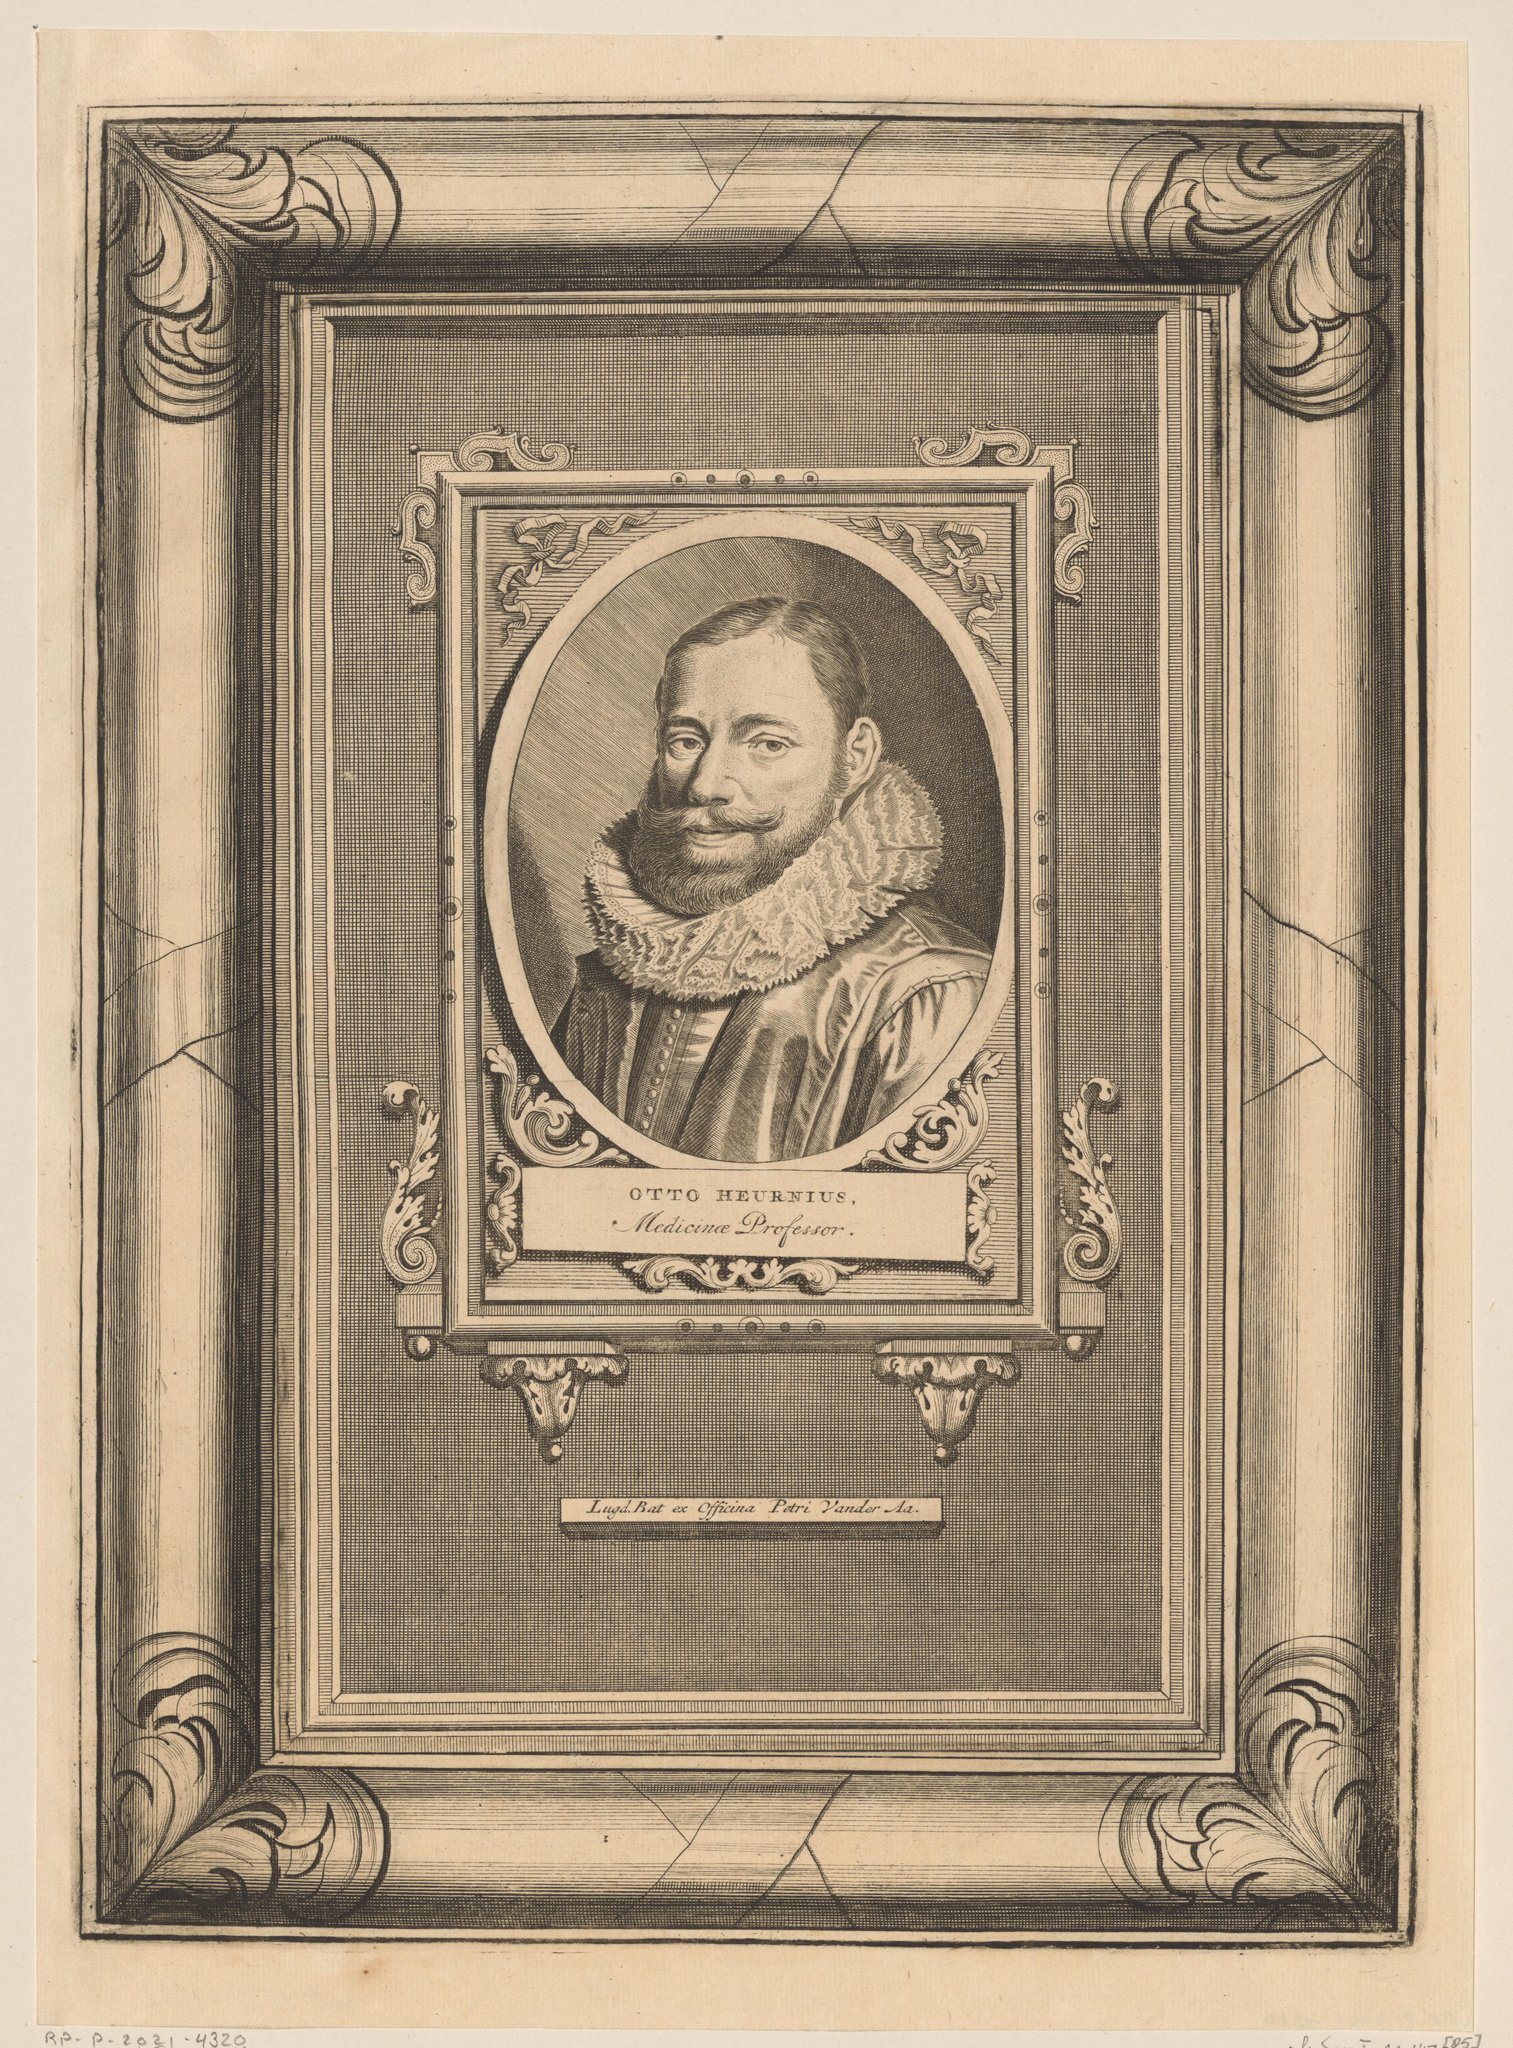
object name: print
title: Portret van Otto Heurnius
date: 1675-1733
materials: paper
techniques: engraving, etching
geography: leiden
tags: otto heurnius, historical persons, physician, doctor, professor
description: Prent met enkele omlijsting gebruikt in: Fundatoris, curatorum et professorum celeberrimorum aliorumque illustrium virorum (...). Leiden: Pieter van der Aa, 1716.